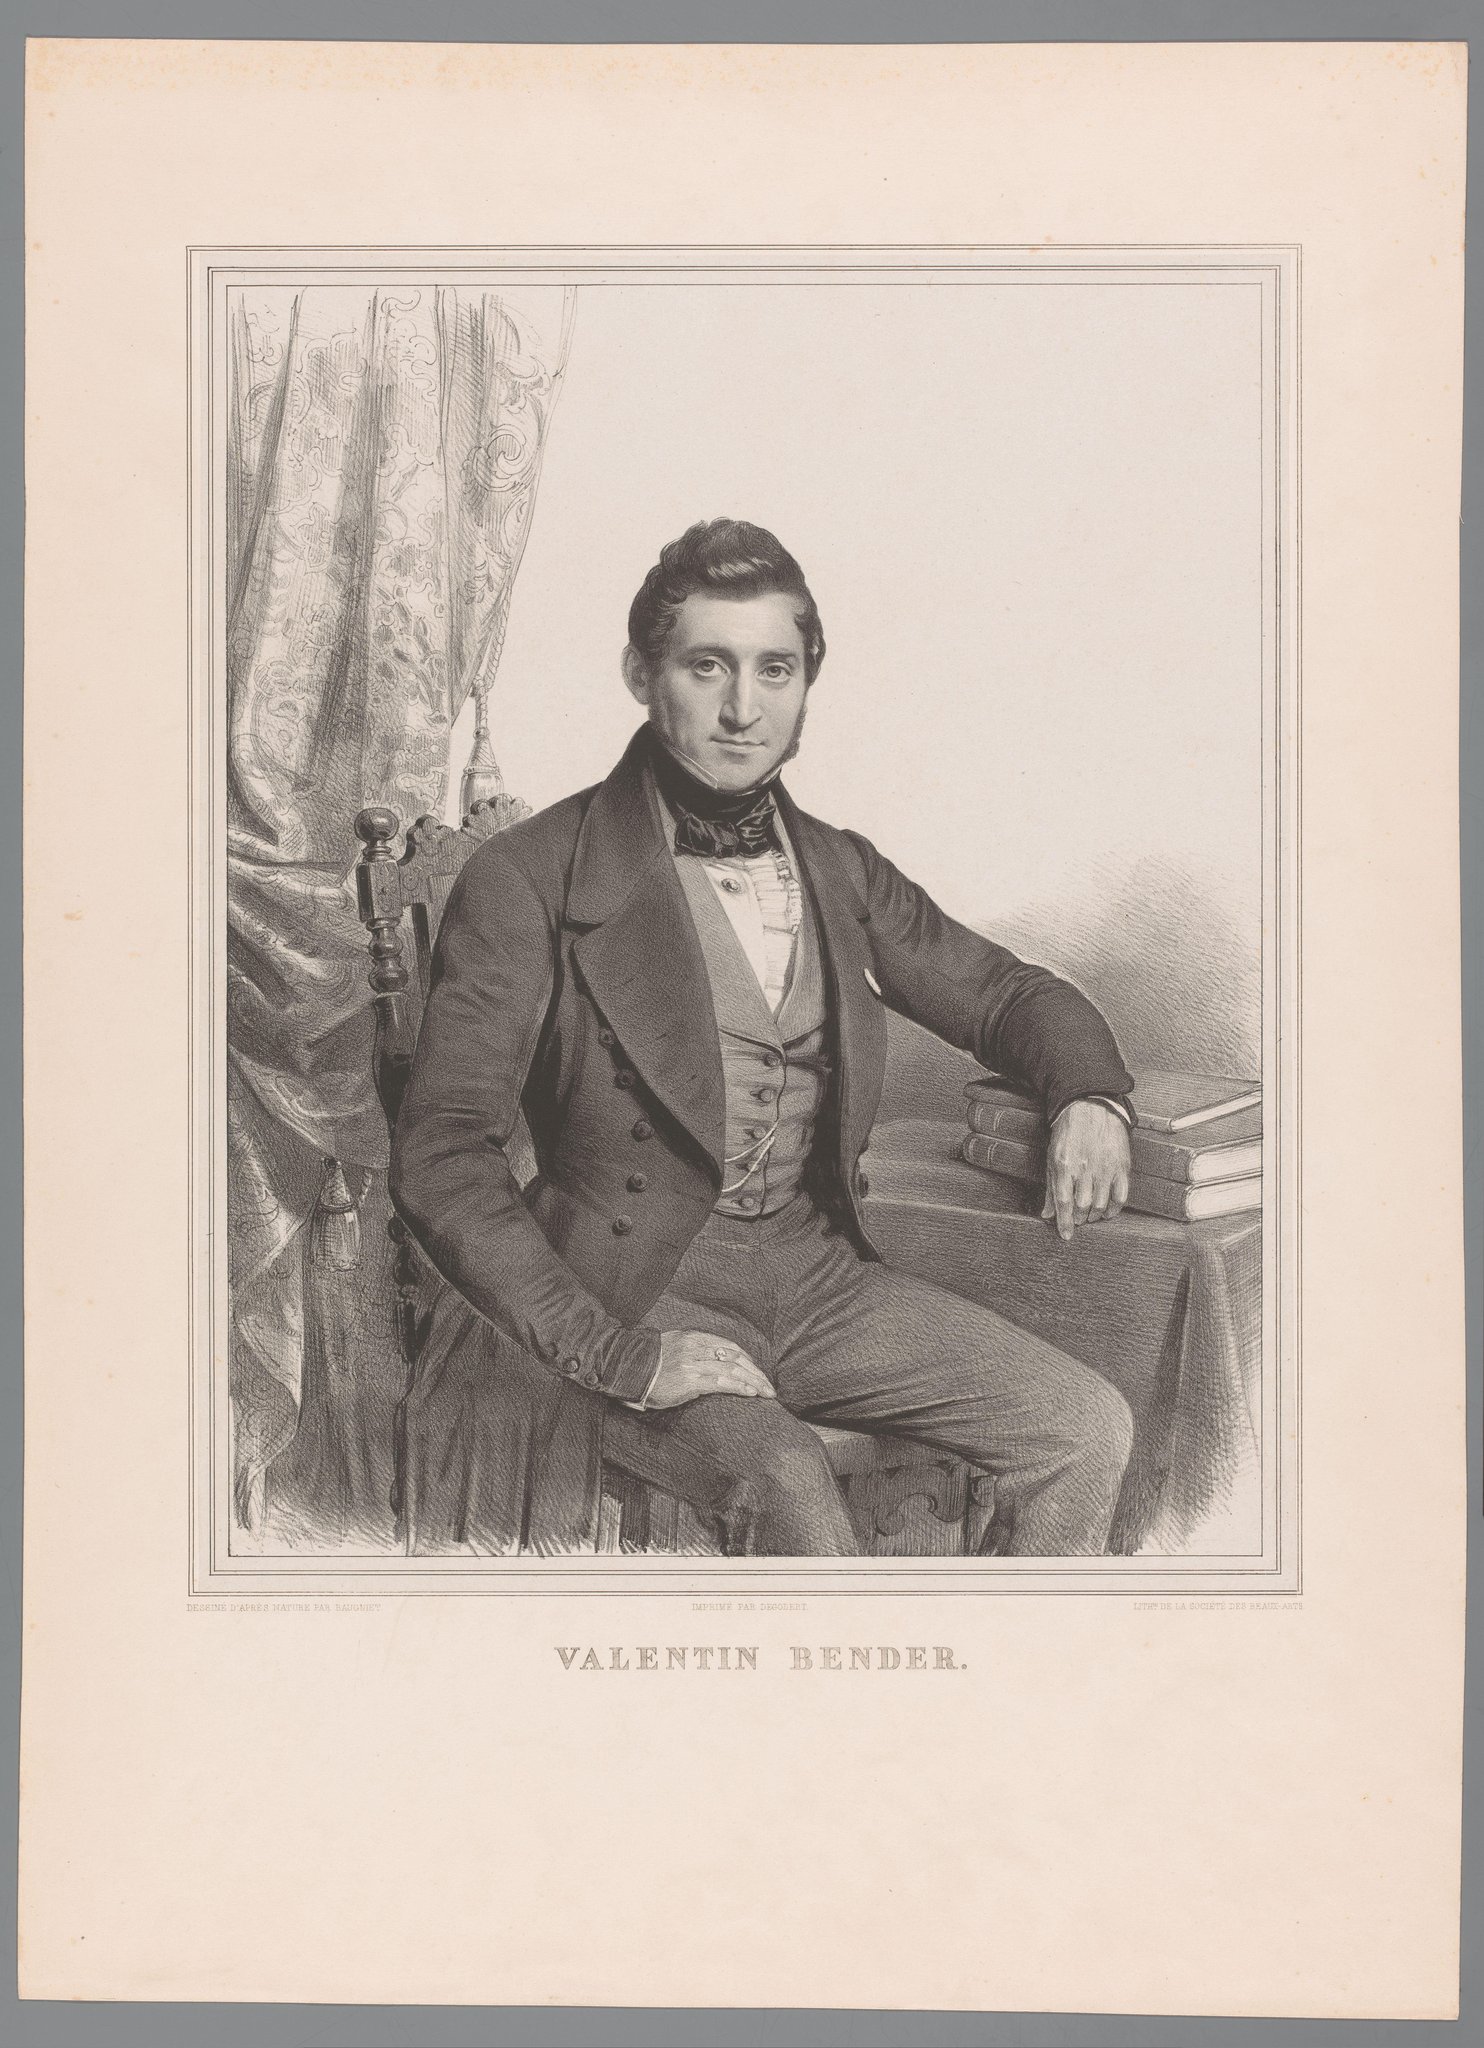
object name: print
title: Portret van Jean-Valentin Bender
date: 1839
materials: paper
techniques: lithograph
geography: brussels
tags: adult man, historical persons, book, chair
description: Prent verschenen in: Baugniet, Charles. Les artistes contemporains: portraits lithographiés d'après nature, accompagnés de notices sur la vie et les ouvrages de chacun d'eux. Brussel: De Wasme-Pletinckx, [1836-1840].